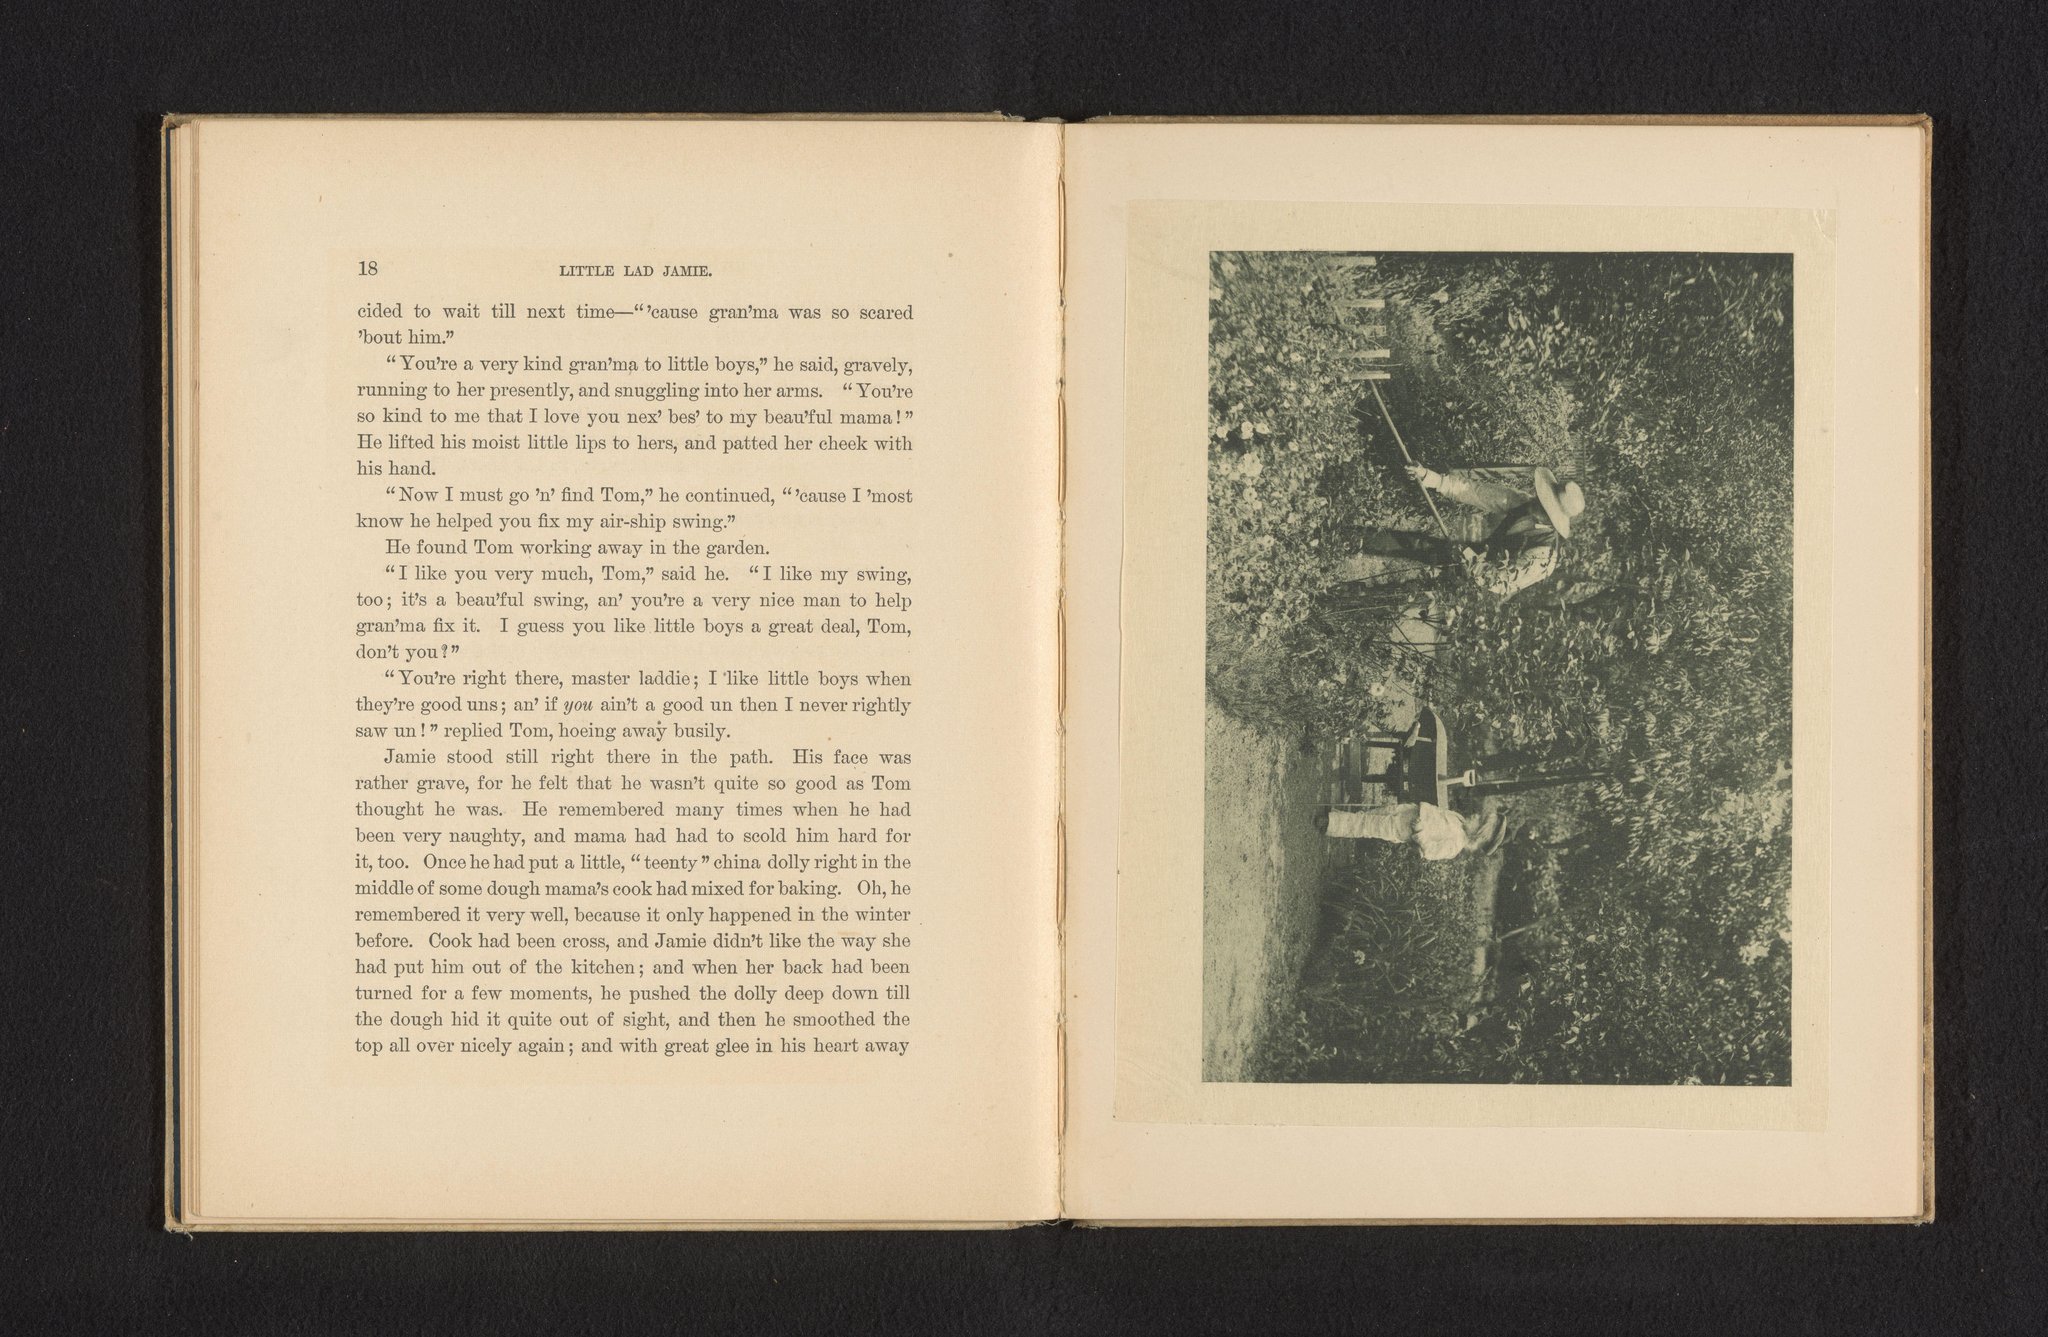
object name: photomechanical print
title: Jongen en een man werken in een tuin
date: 1890-1895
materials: paper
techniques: photoaquatint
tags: boy (child between toddler and youth), adult man, gardening